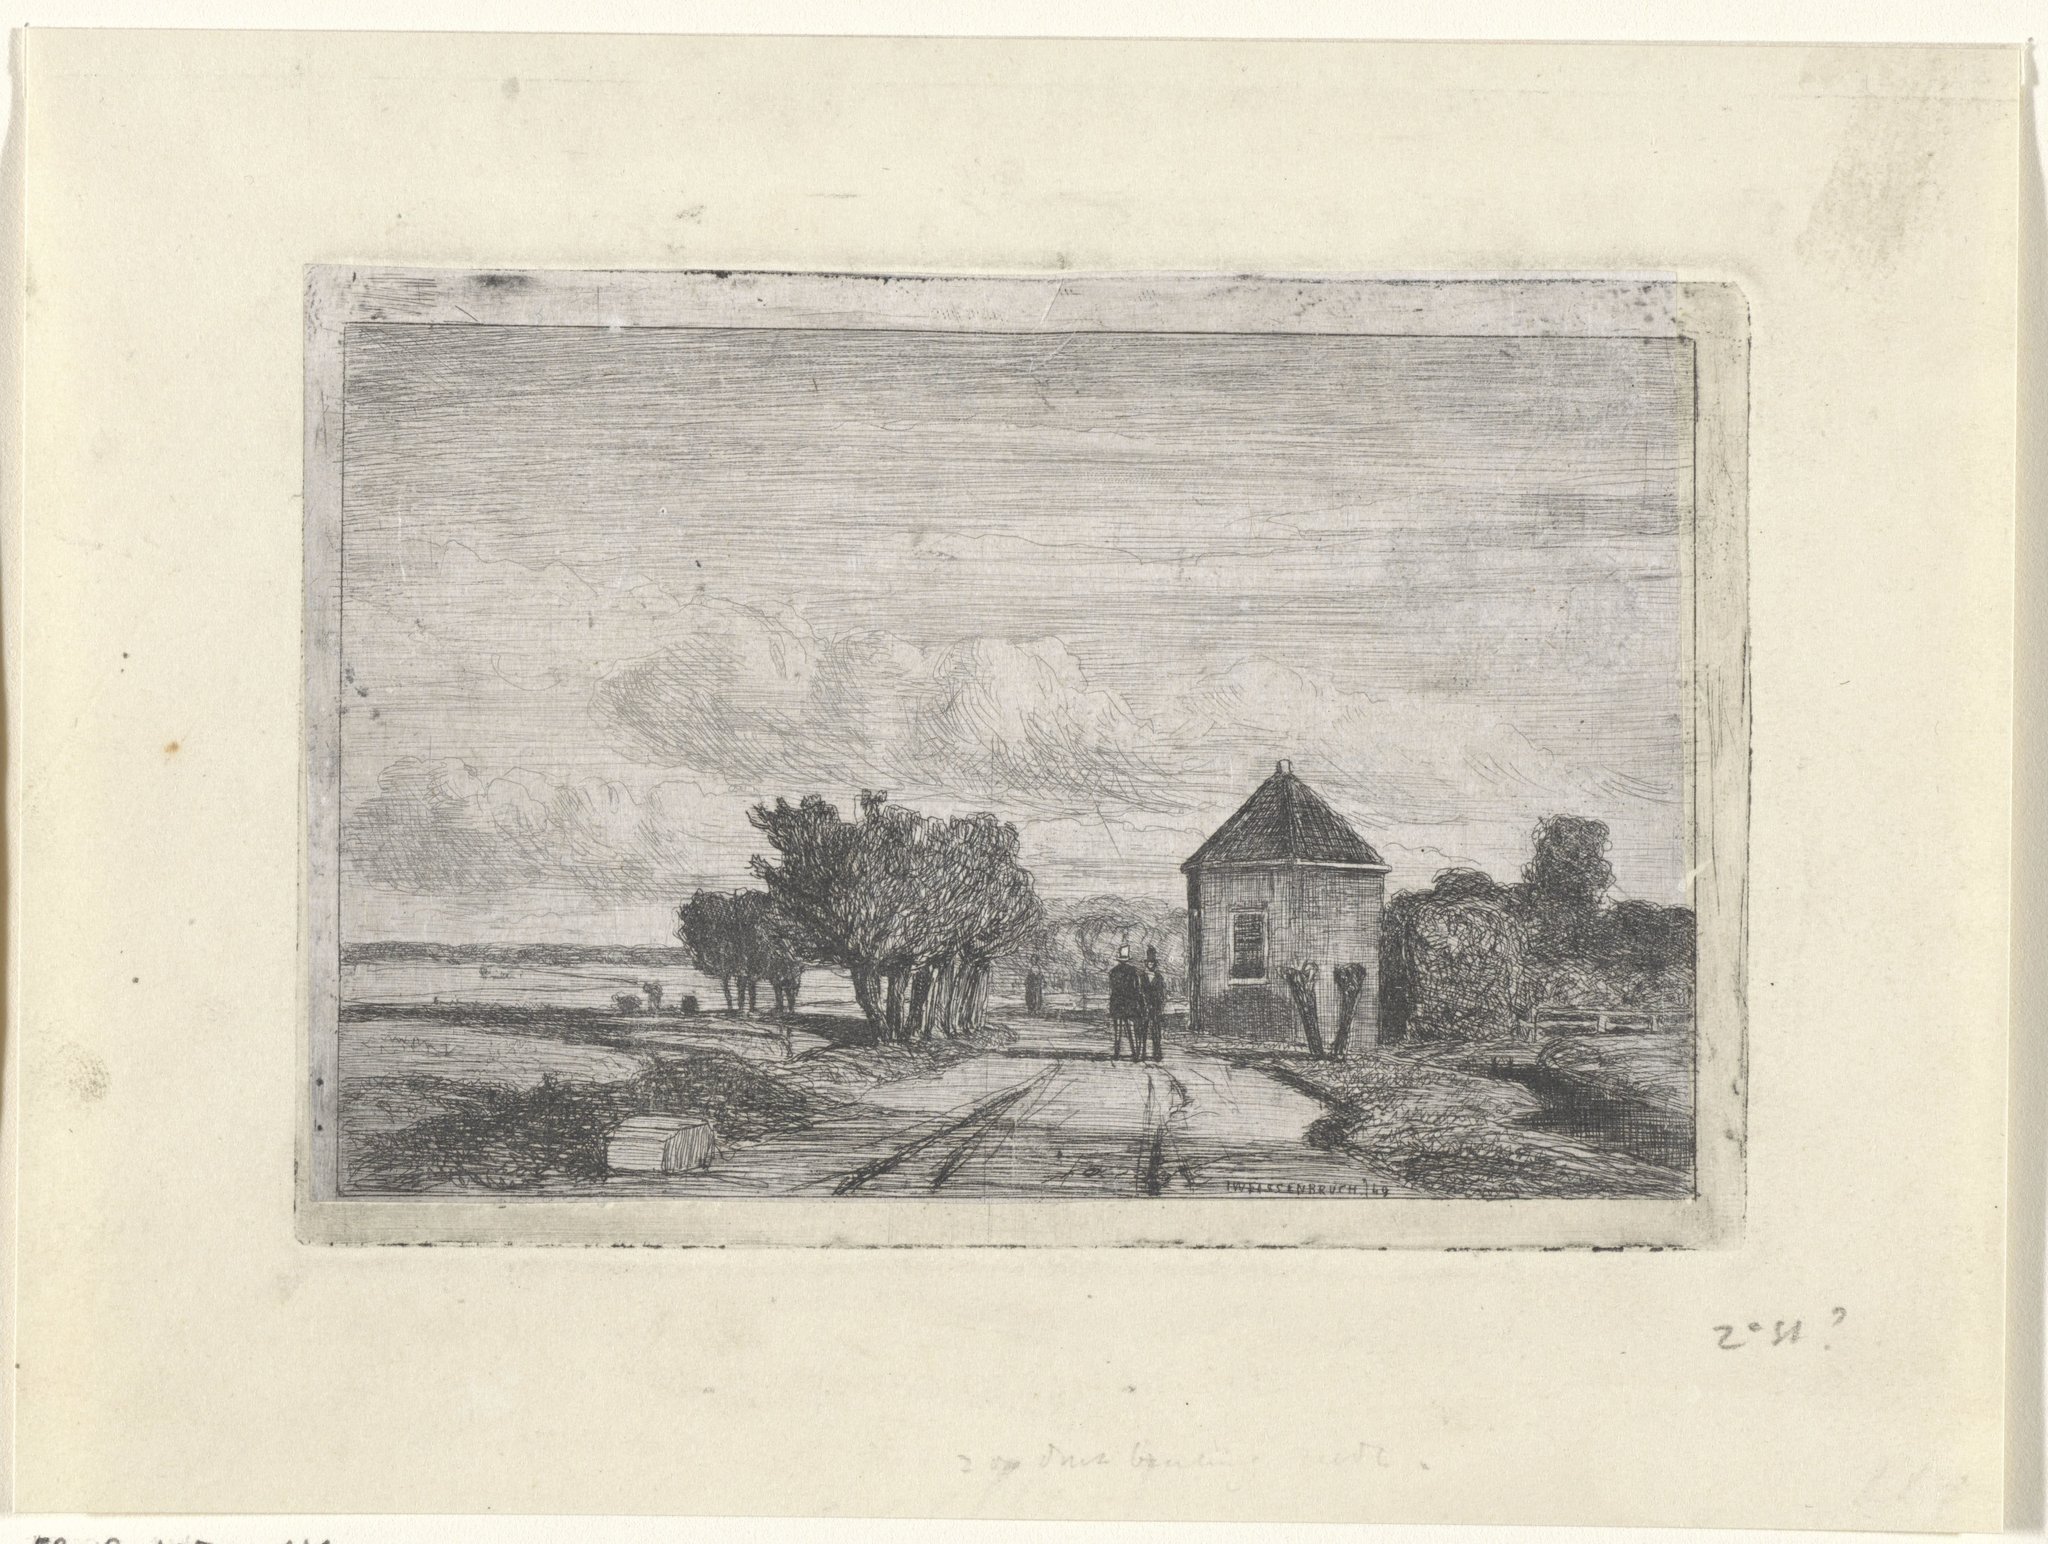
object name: print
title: Gezicht op de Schenkweg met de Koepel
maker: jan weissenbruch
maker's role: painter, print maker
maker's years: 1822-1880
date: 1849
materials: paper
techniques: etching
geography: the hague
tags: trees, landscapes, adult man, road, path, workshop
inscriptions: date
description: Langs de Schenkweg te Den Haag staan enkele bomen. Rechts staat een gebouw dat door de kunstenaar Johannes van der Drift als atelier werd gebruikt. Op de weg staan enkele figuren, onder wie mogelijk leden van de Haagsche Etsclub.